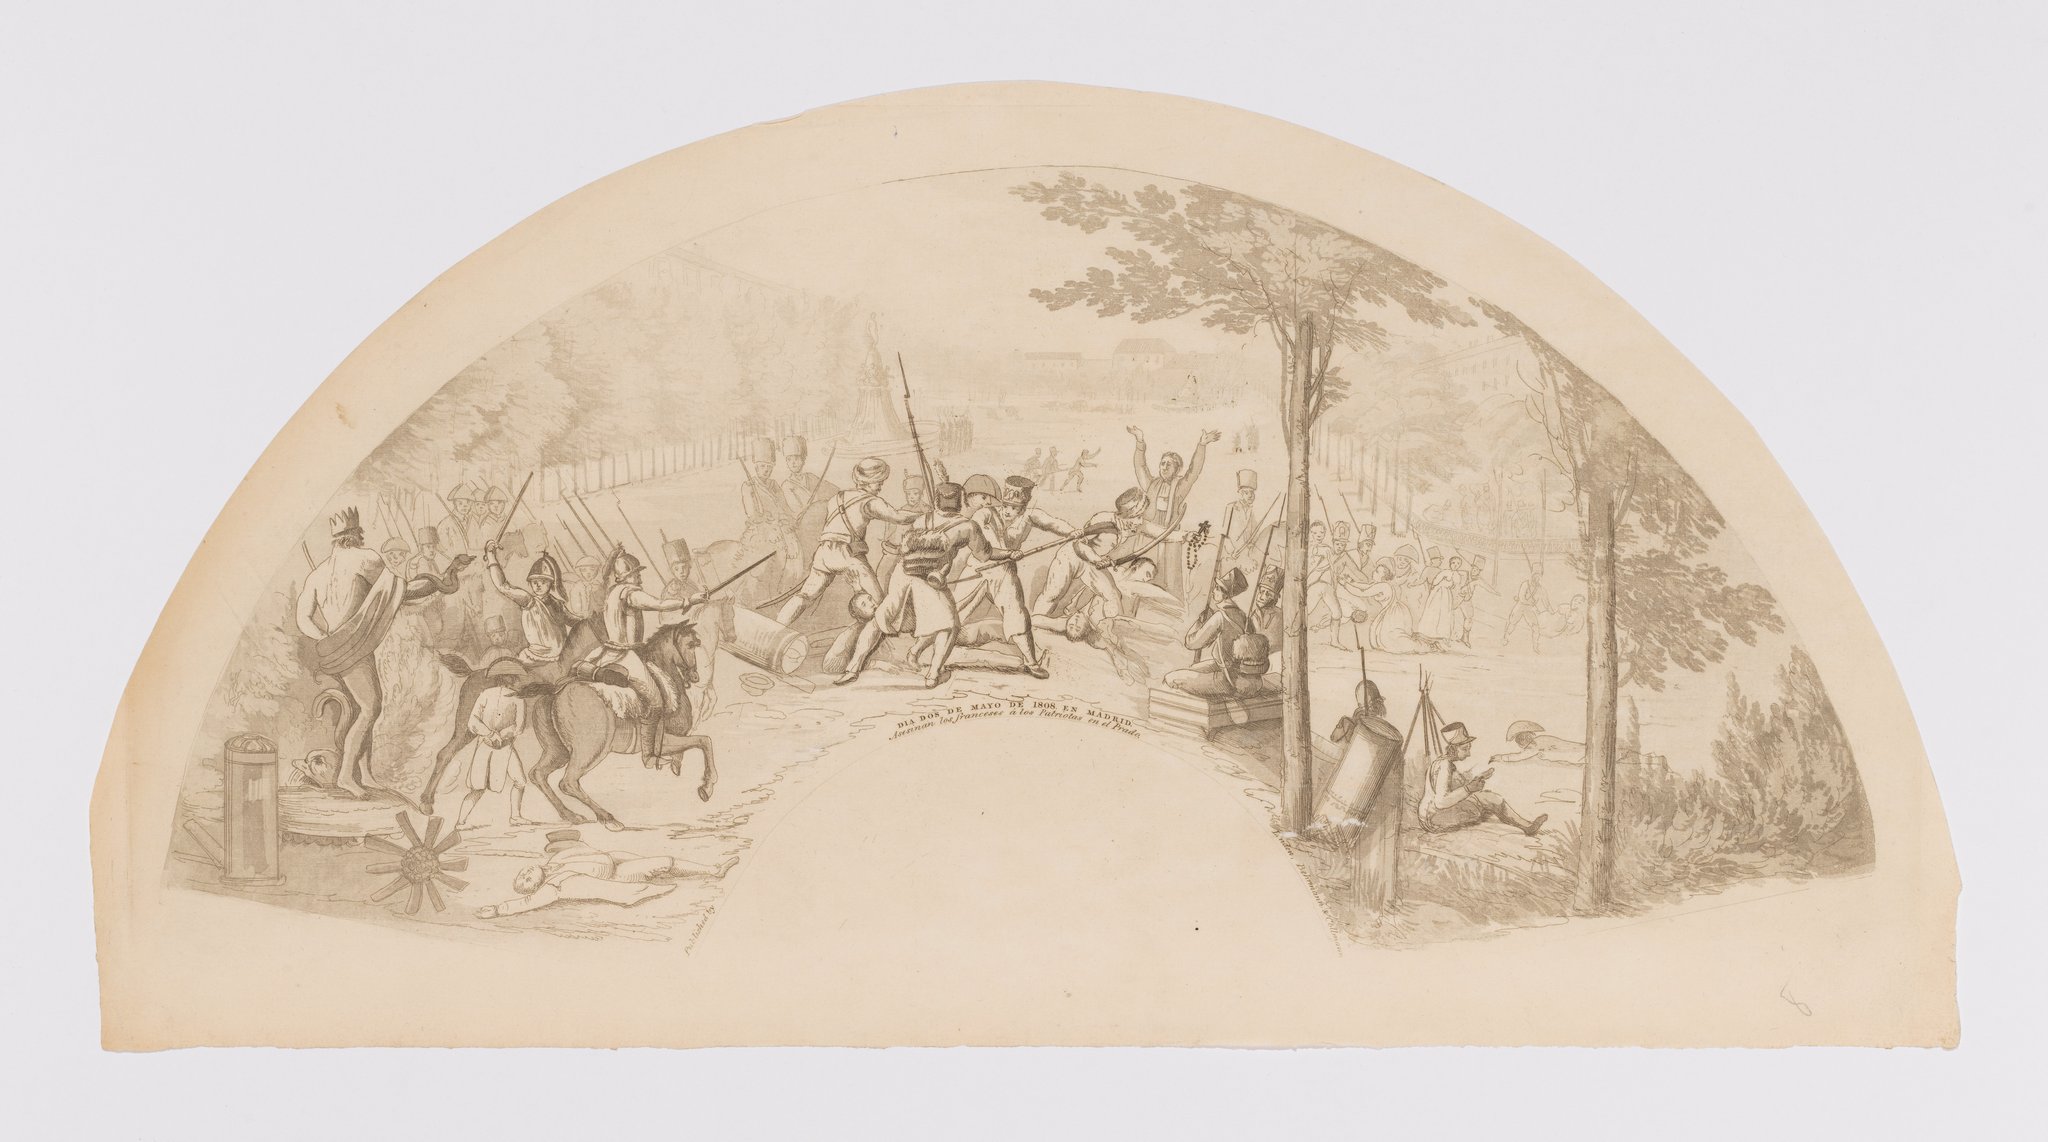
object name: print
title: The French Murder the Patriots in the Prado (Asesinan los franceses a los Patriotas en el Prado)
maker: anonymous, british, 19th century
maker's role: artist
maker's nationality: british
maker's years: 1800-1900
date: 1813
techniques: aquatint, etching